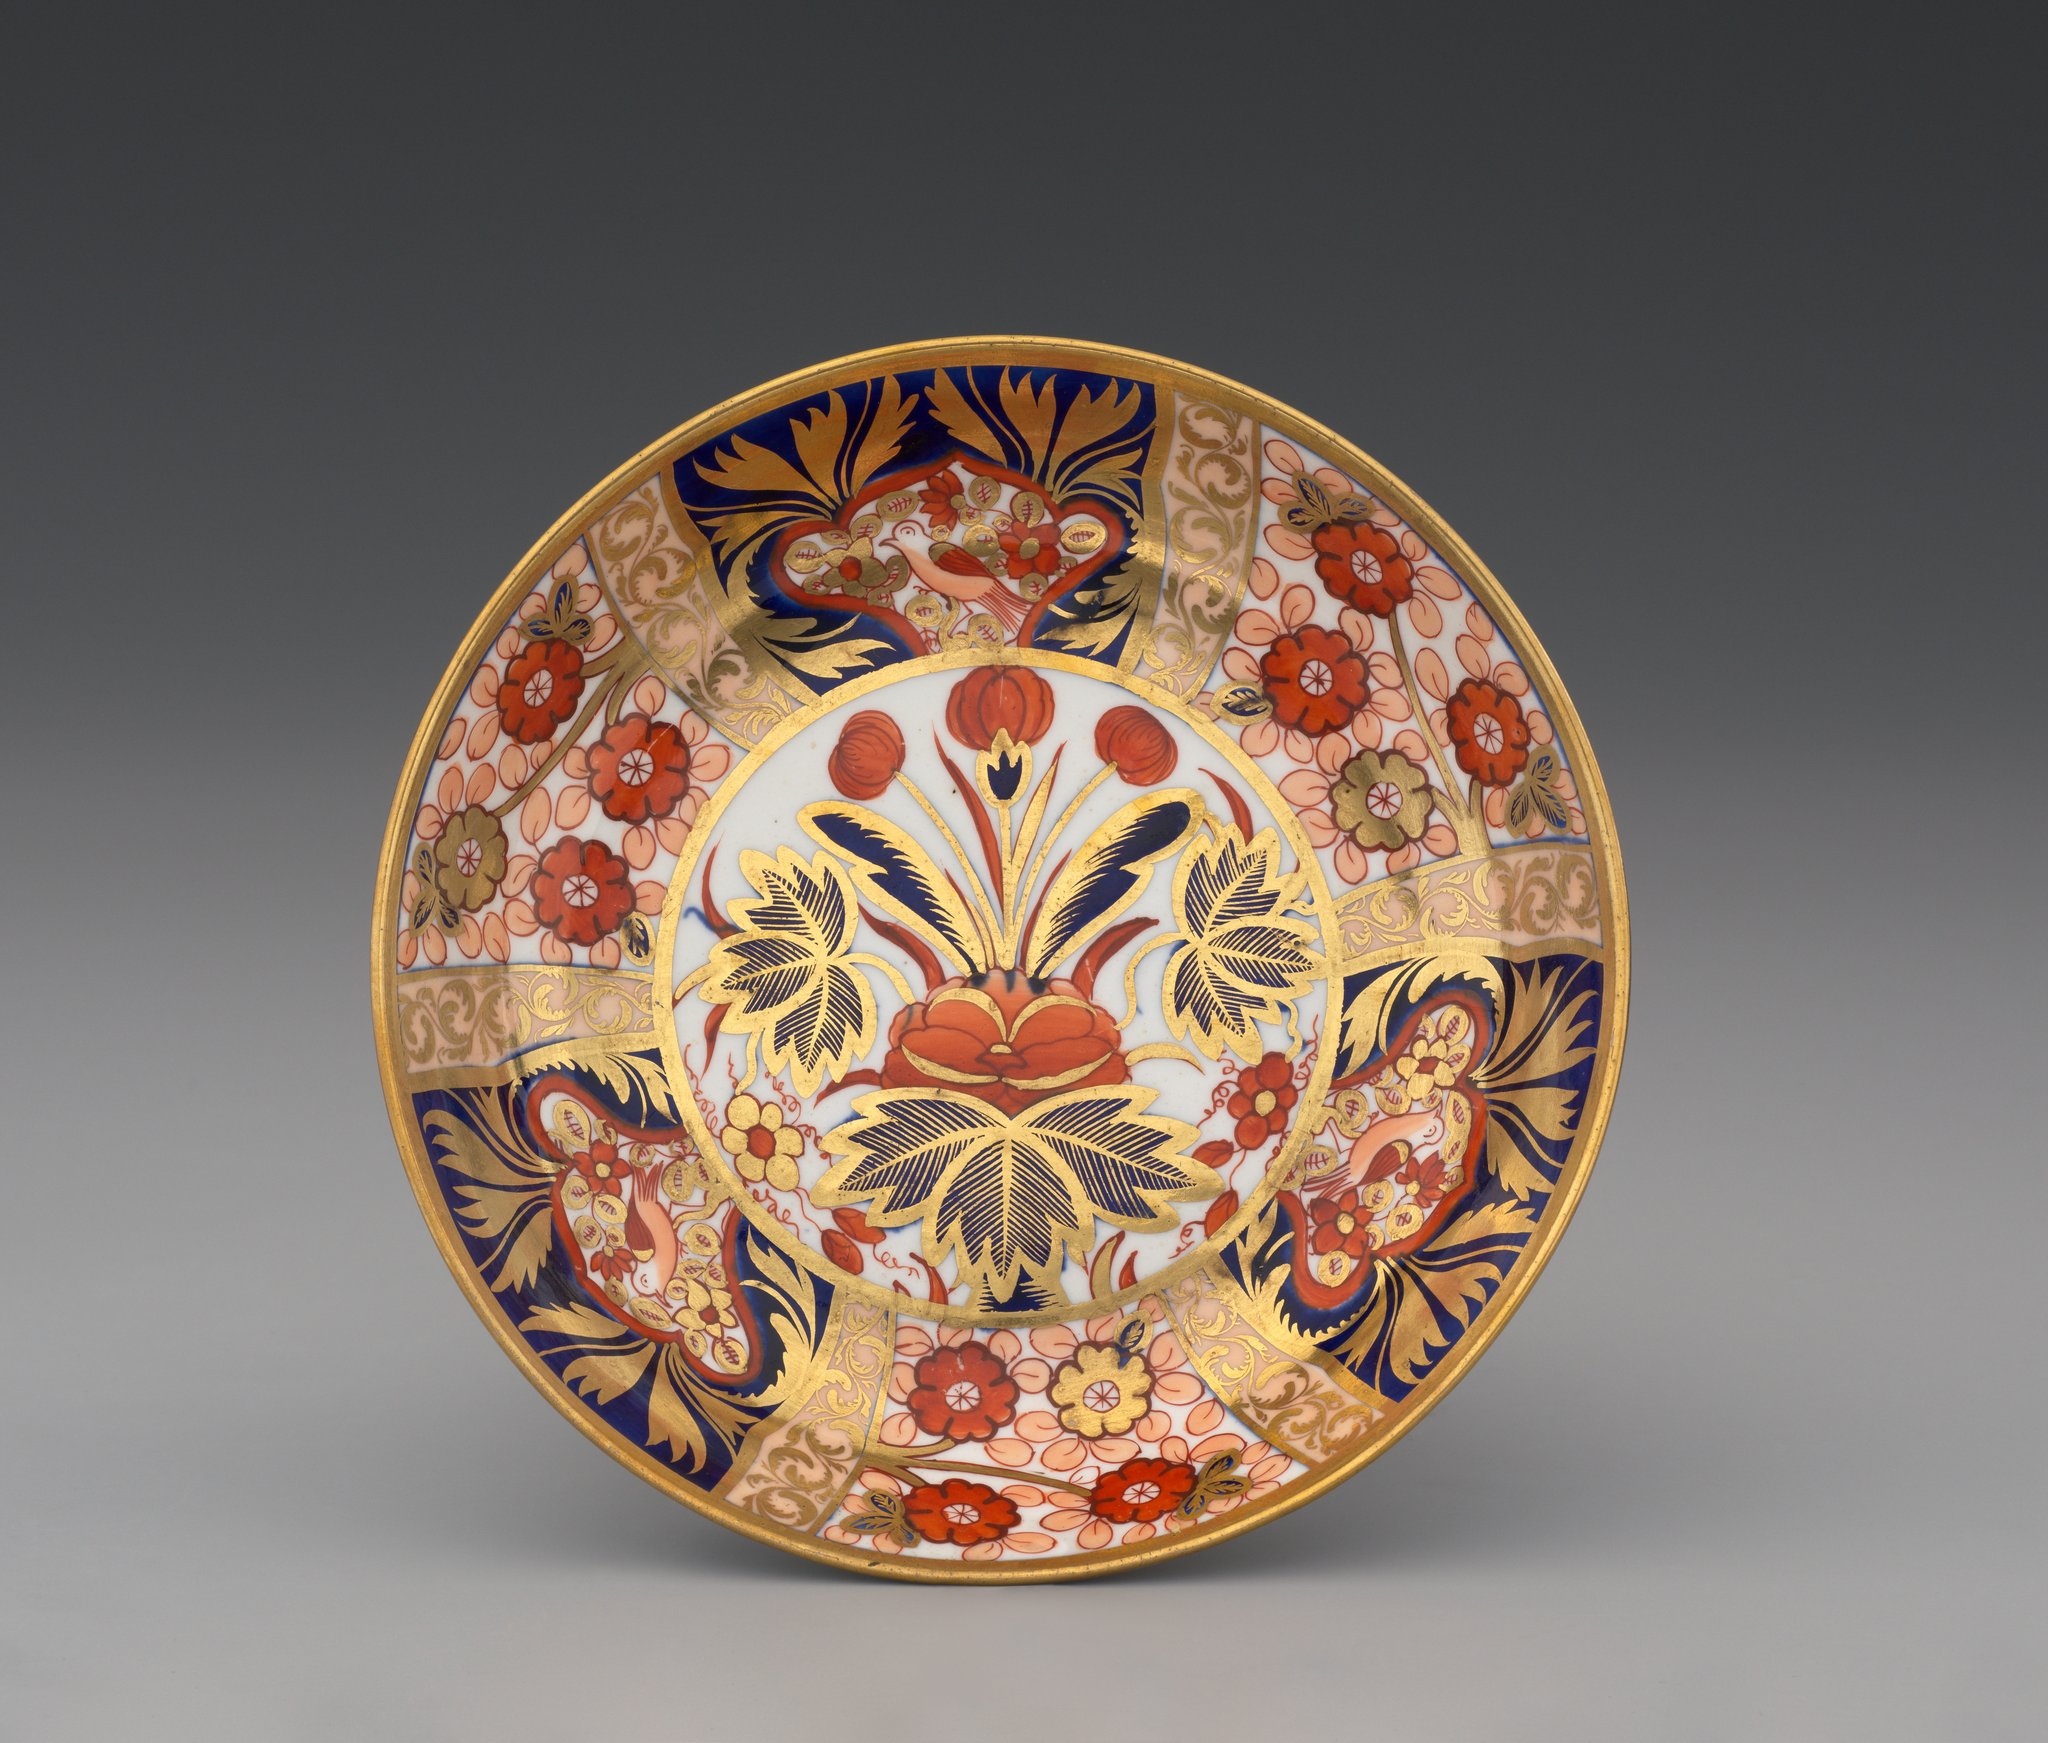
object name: saucer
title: Saucer (part of a service)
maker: j. spode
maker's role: factory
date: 1800-1830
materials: soft paste porcelain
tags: birds